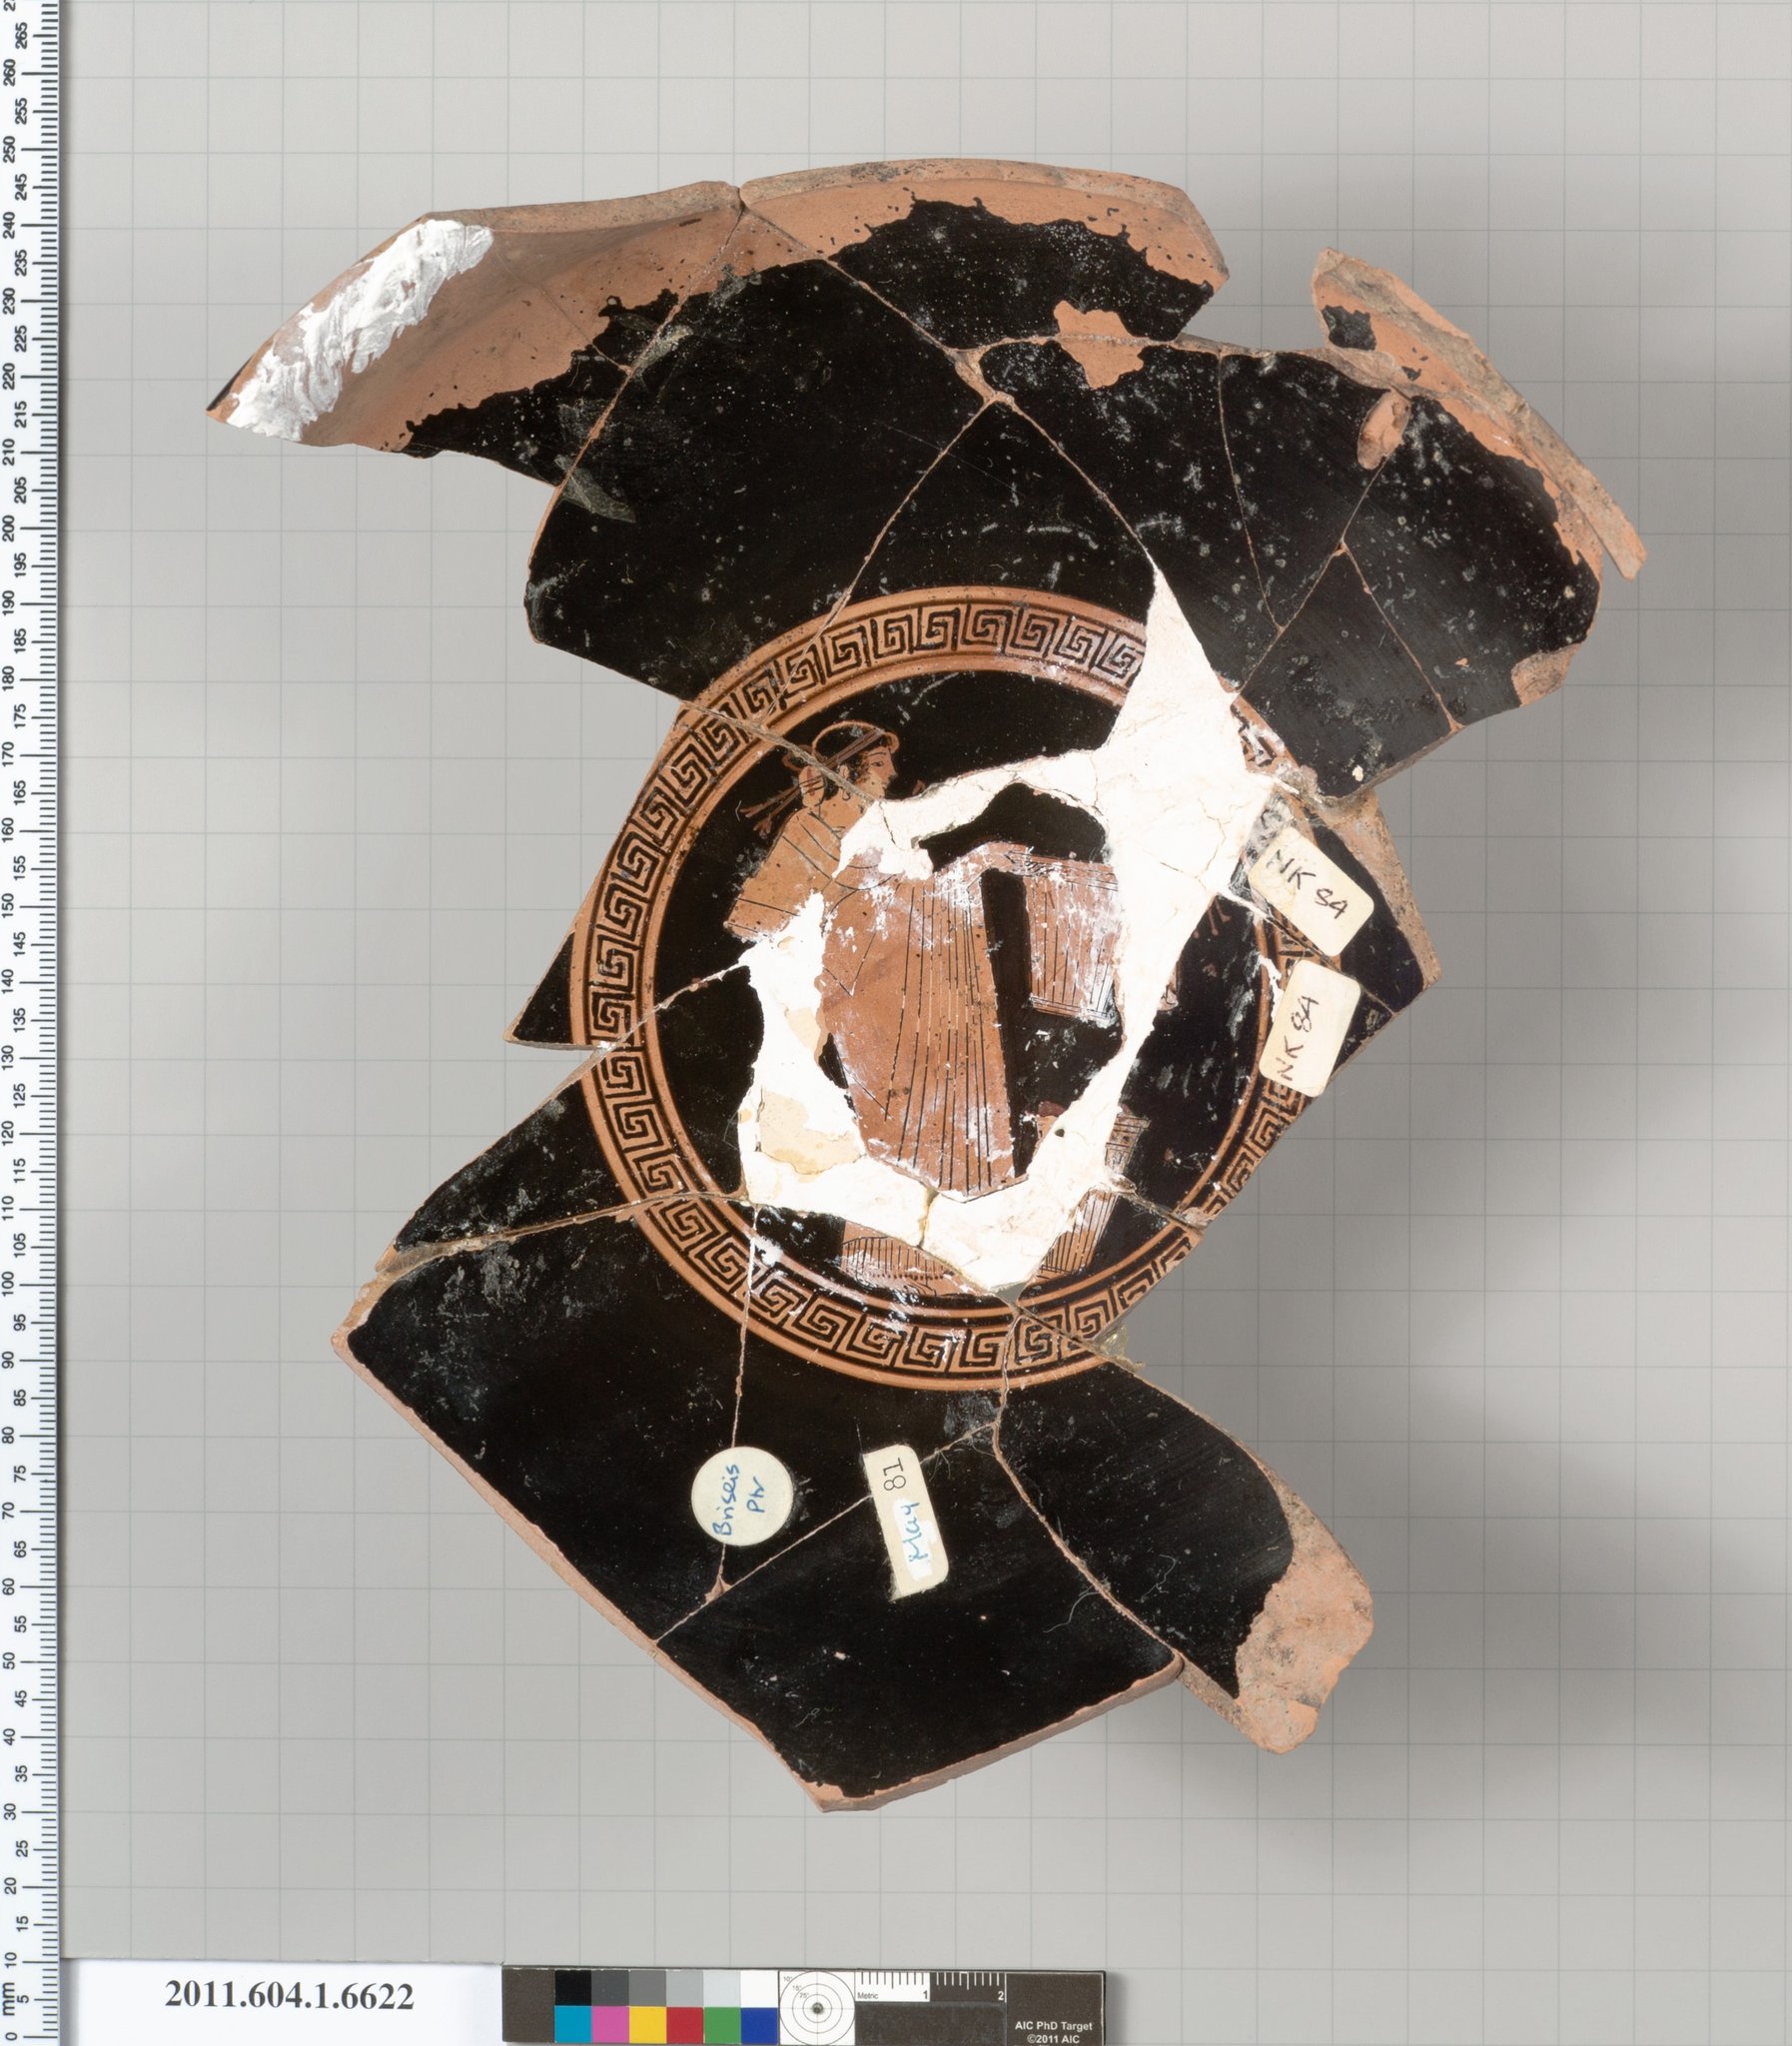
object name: kylix fragment, lipped inside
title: Terracotta fragment of a kylix (drinking cup)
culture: greek, attic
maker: briseis painter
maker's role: artist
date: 480-470 BCE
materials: terracotta